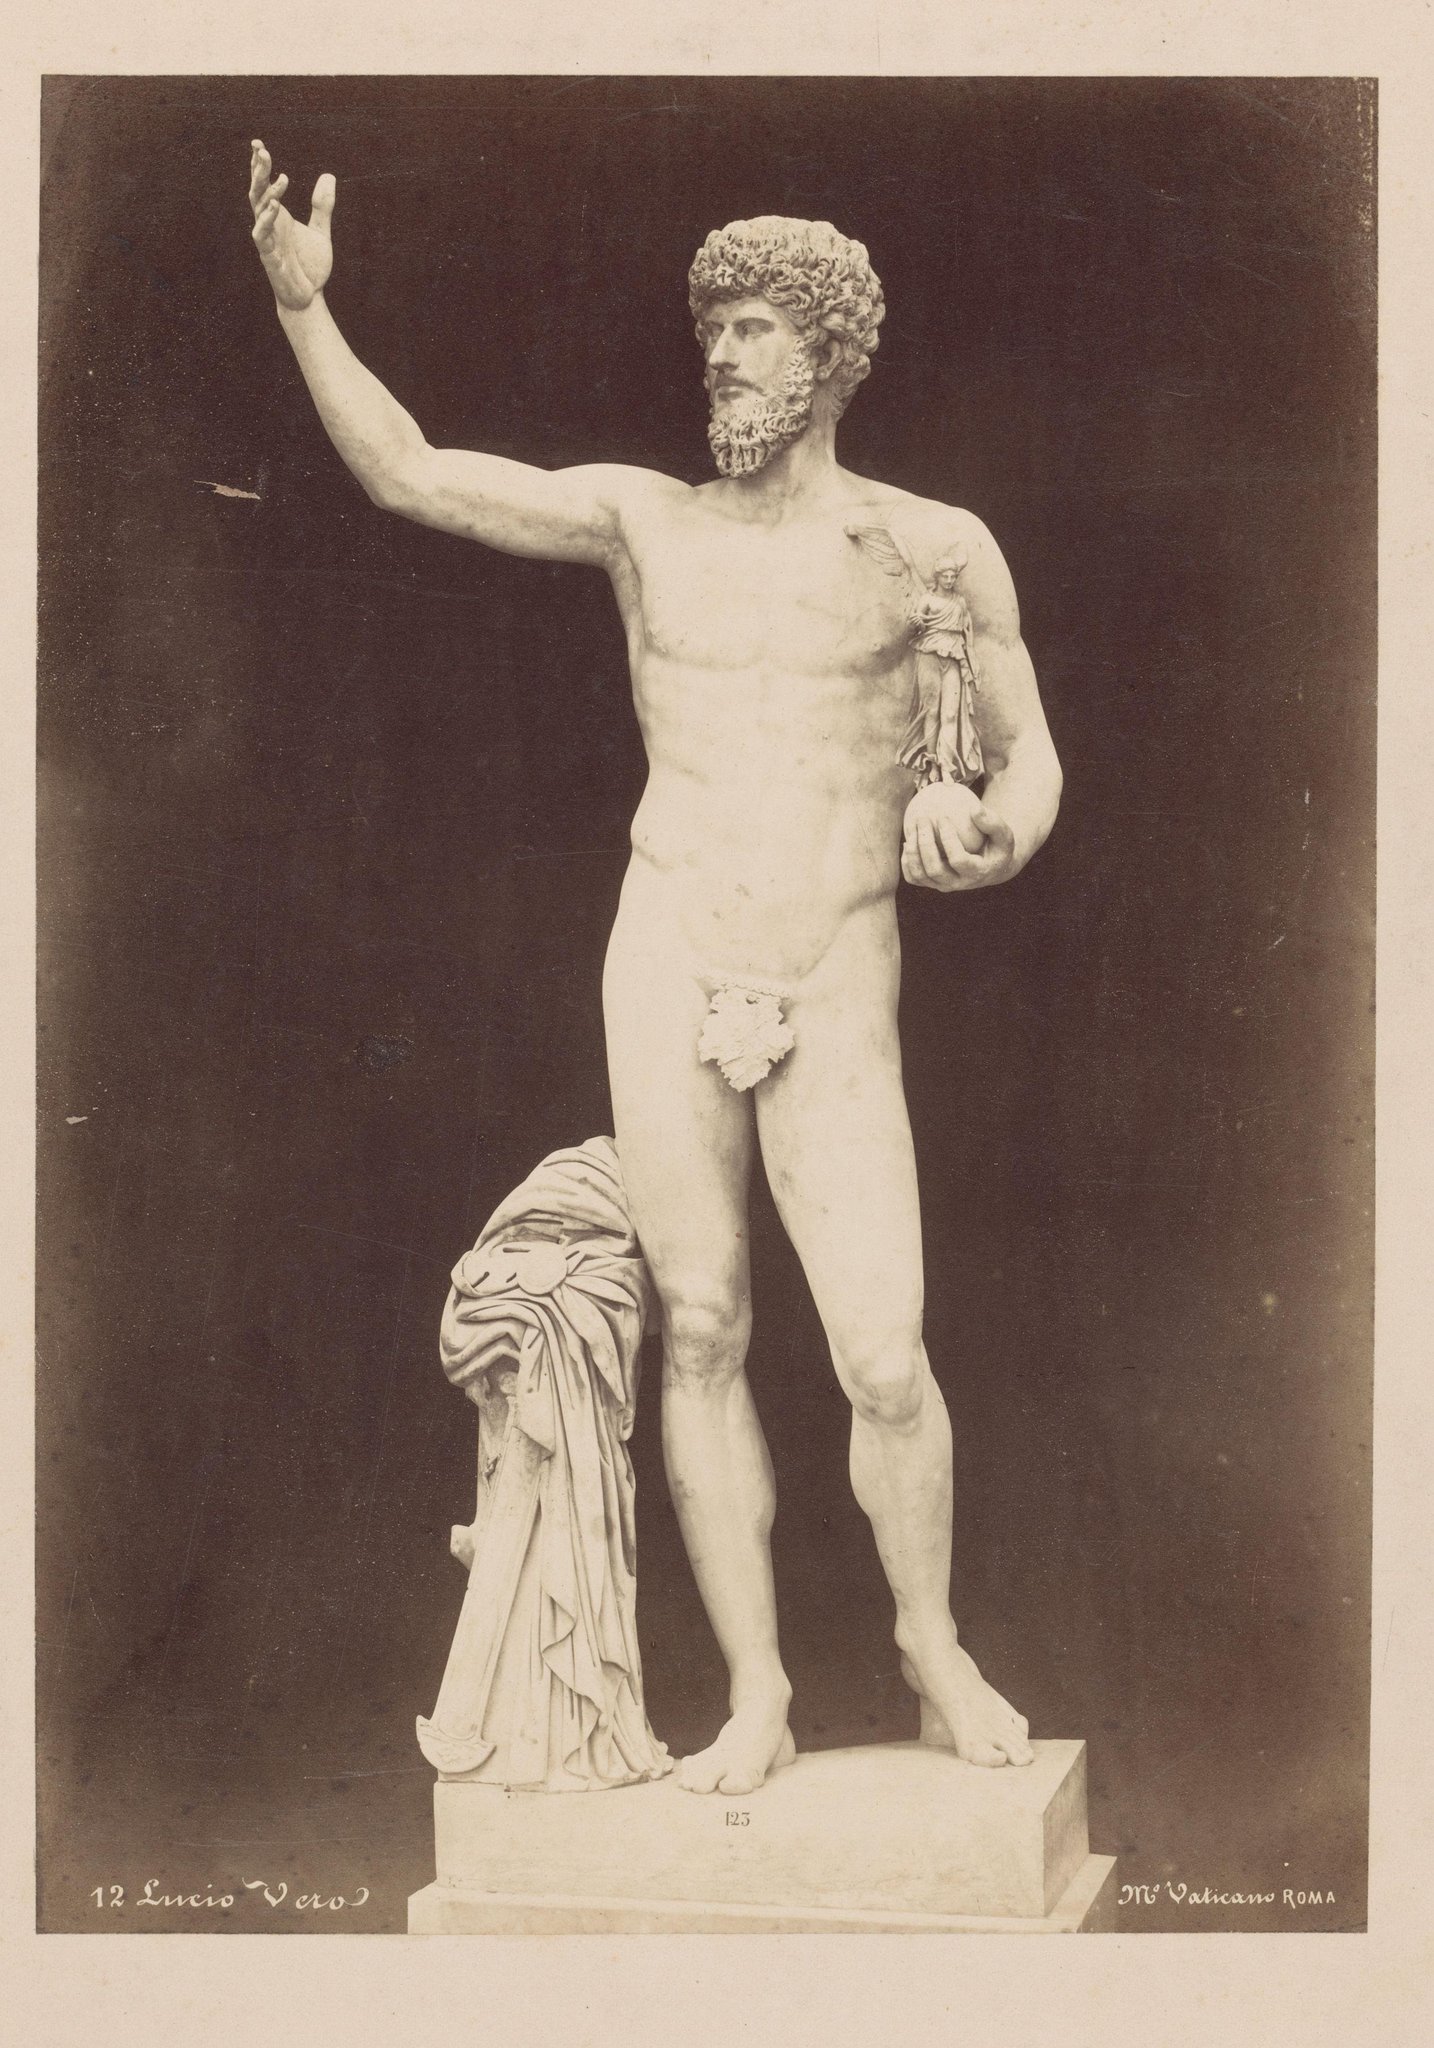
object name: photograph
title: Lucio Vero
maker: Anonymous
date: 1880-1900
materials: cardboard, paper, photographic support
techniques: albumen print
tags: vaticaanse musea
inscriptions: : ‘12 Lucio Vero Mo Vaticano ROMA’, stamp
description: Sculptuur van een staande man met baard.